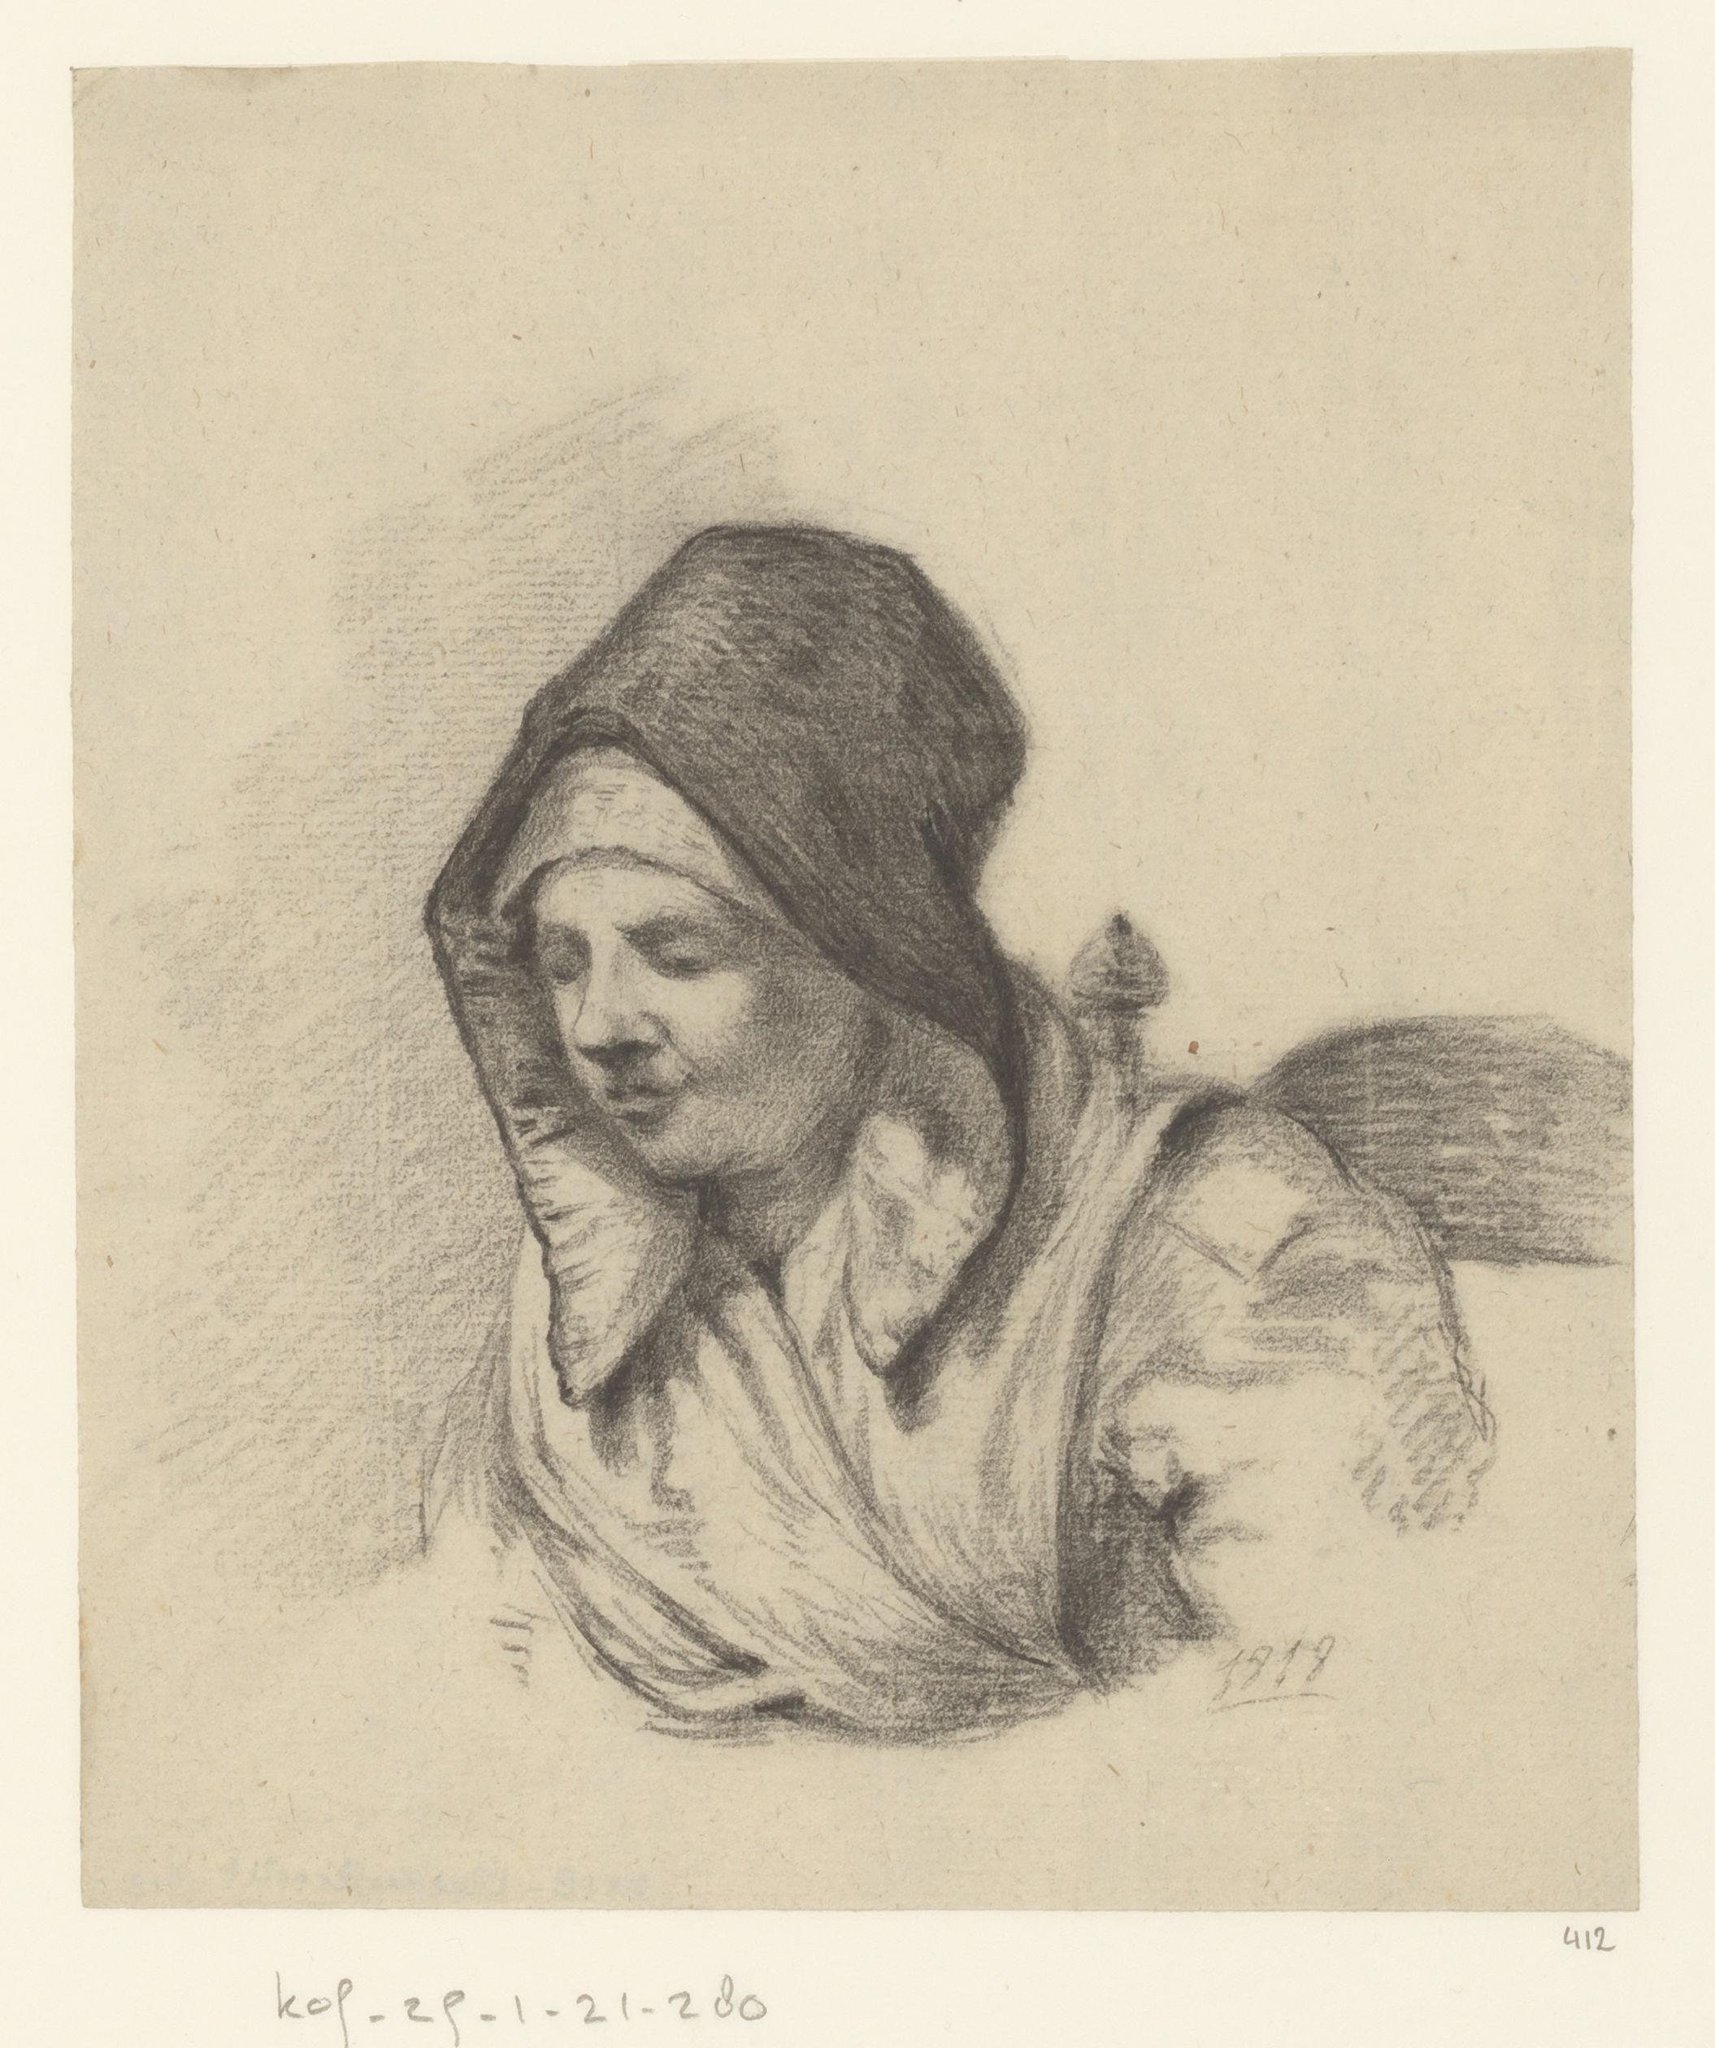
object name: drawing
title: Zittende vrouw met neergeslagen ogen zit op een stoel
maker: jean bernard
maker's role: draughtsman, print maker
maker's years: 1765-1833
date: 1818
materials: chalk, paper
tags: adult woman, head-gear: cap, sleeping; unconsciousness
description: Onderwerpsrubrieken binnen de Atlas Zeden en Gewoonten: Zeden en Gewoonten in Engeren Zin, De Kleeding, Kleederdrachten (tijdvakken), De regeering van Willem I. Mannen en vrouwen.